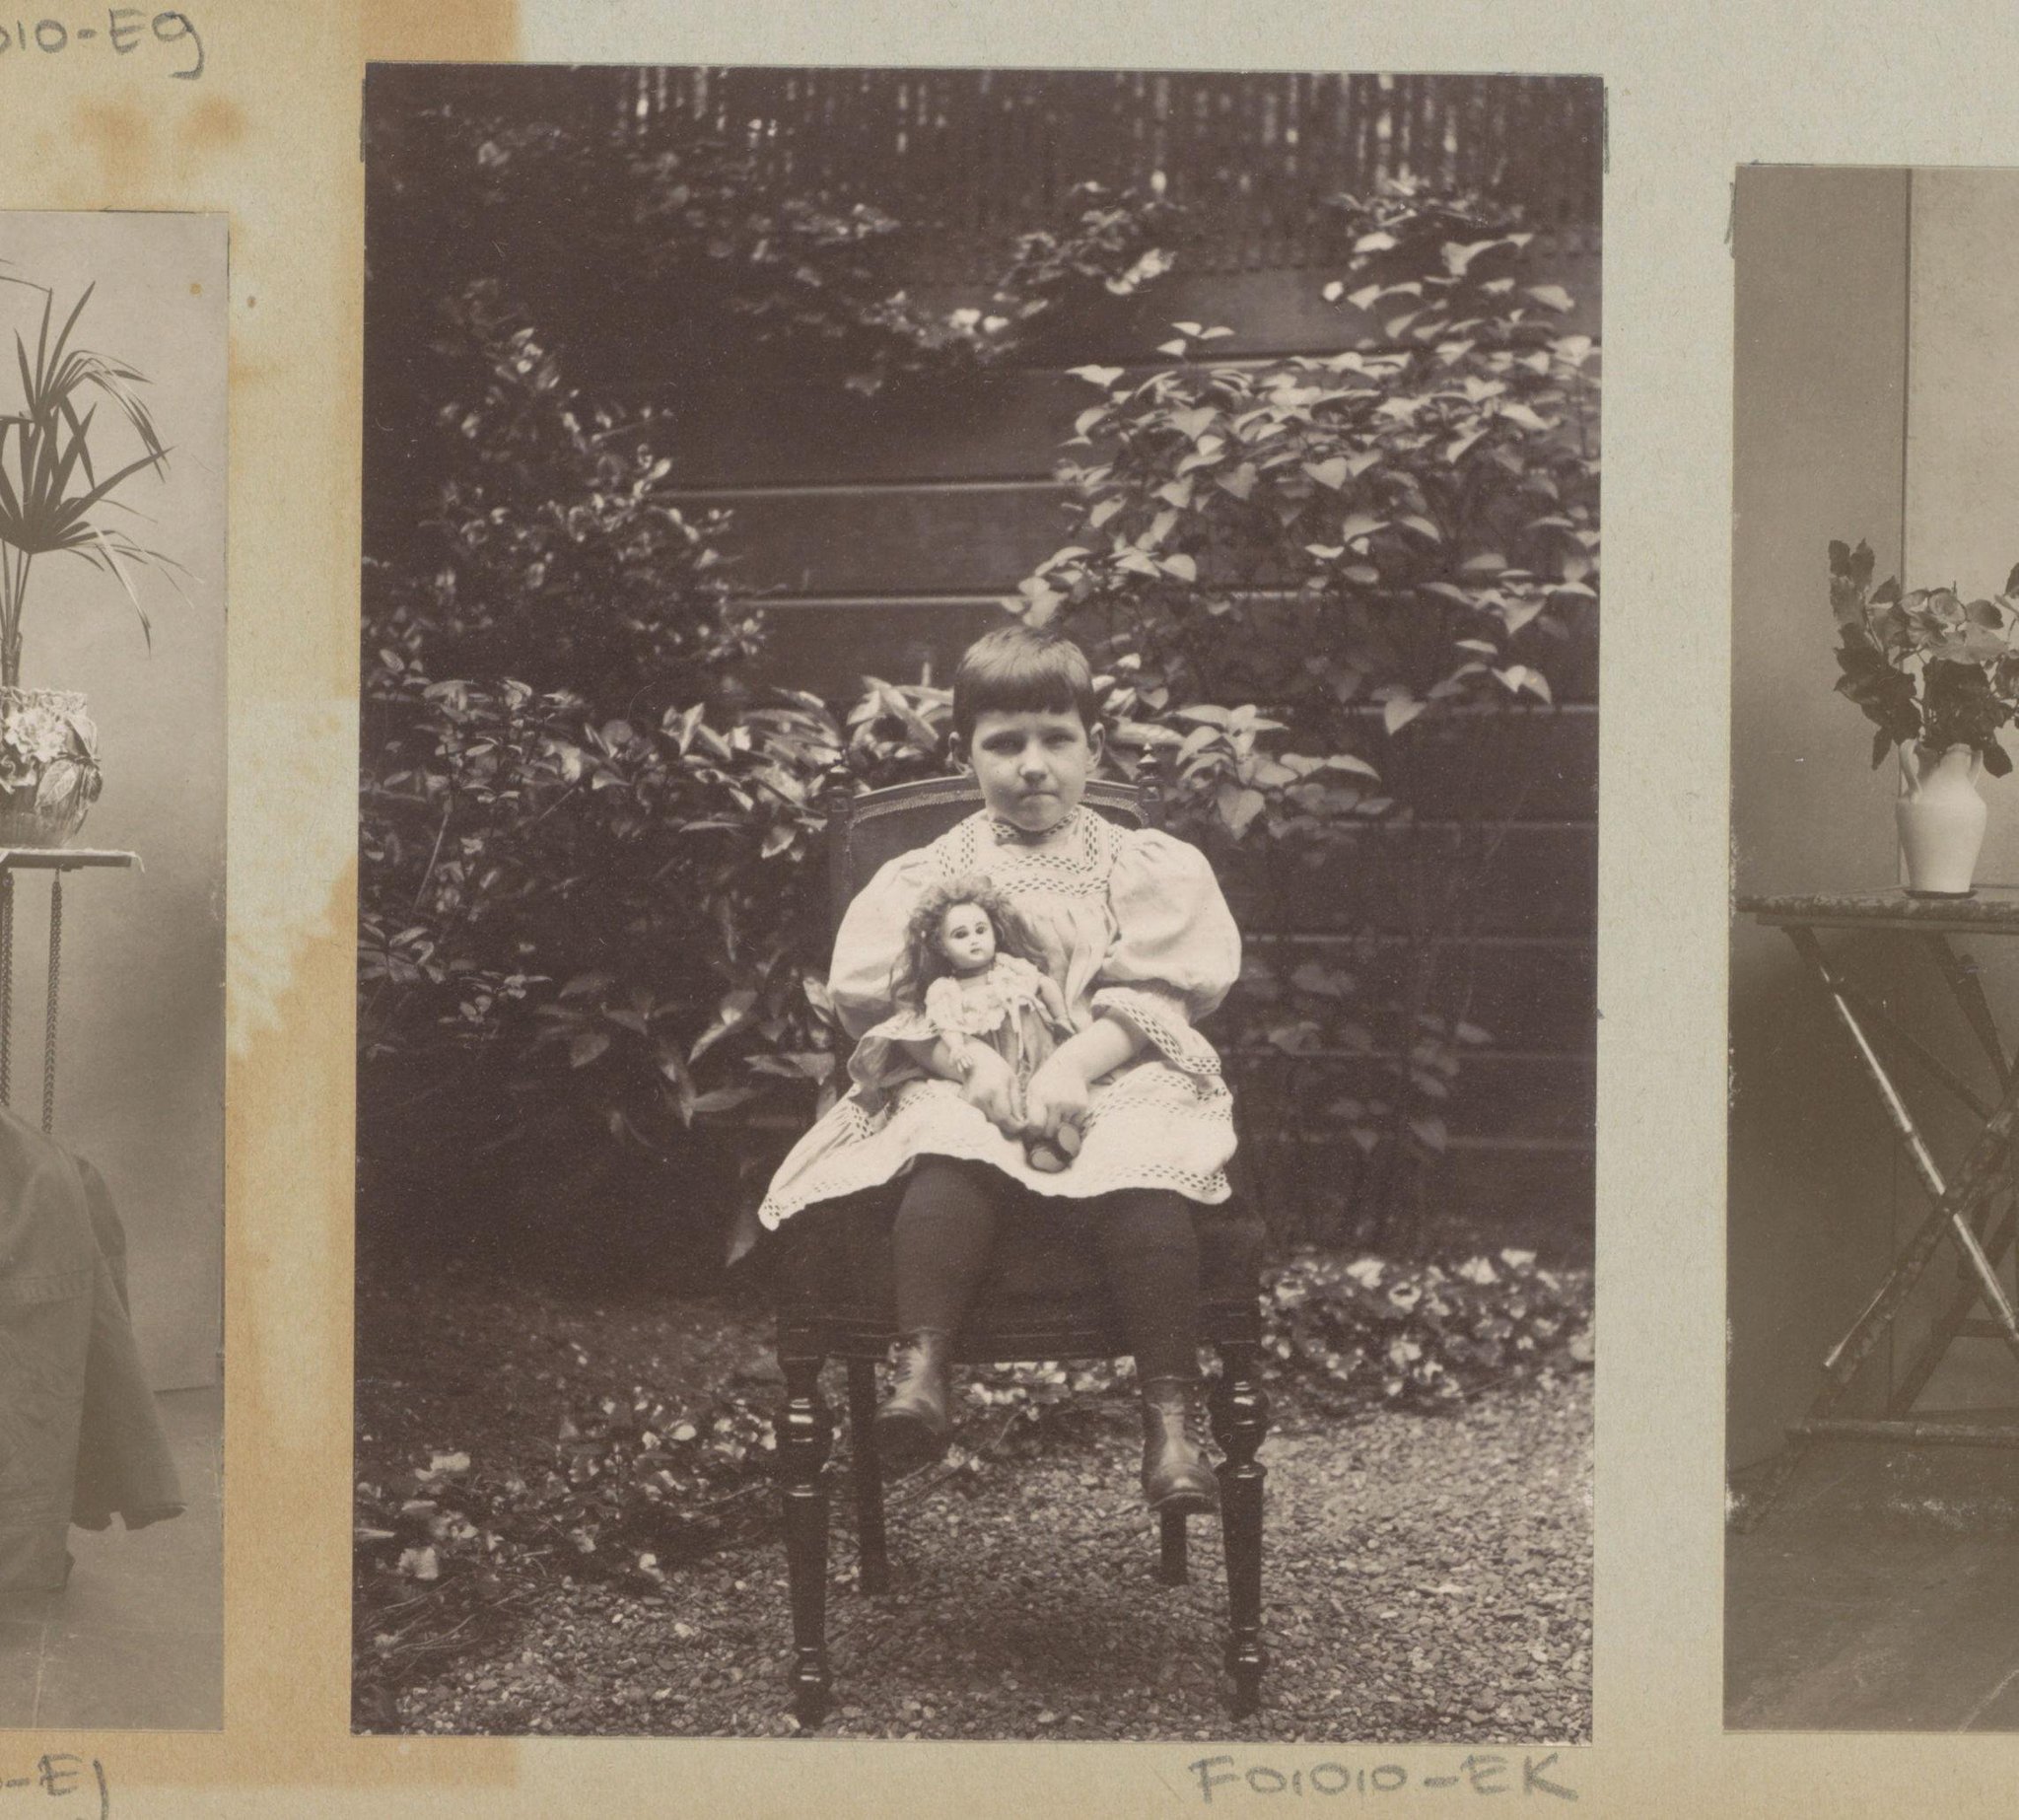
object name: photograph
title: Zittend meisje met een pop in een tuin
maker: Anonymous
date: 1900-1910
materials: photographic support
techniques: gelatin silver print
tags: child, (playing with) dolls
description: Onderdeel van Familiealbum met onder meer foto's van Wijnhandel Kraaij & Co. Bordeaux-Amsterdam.